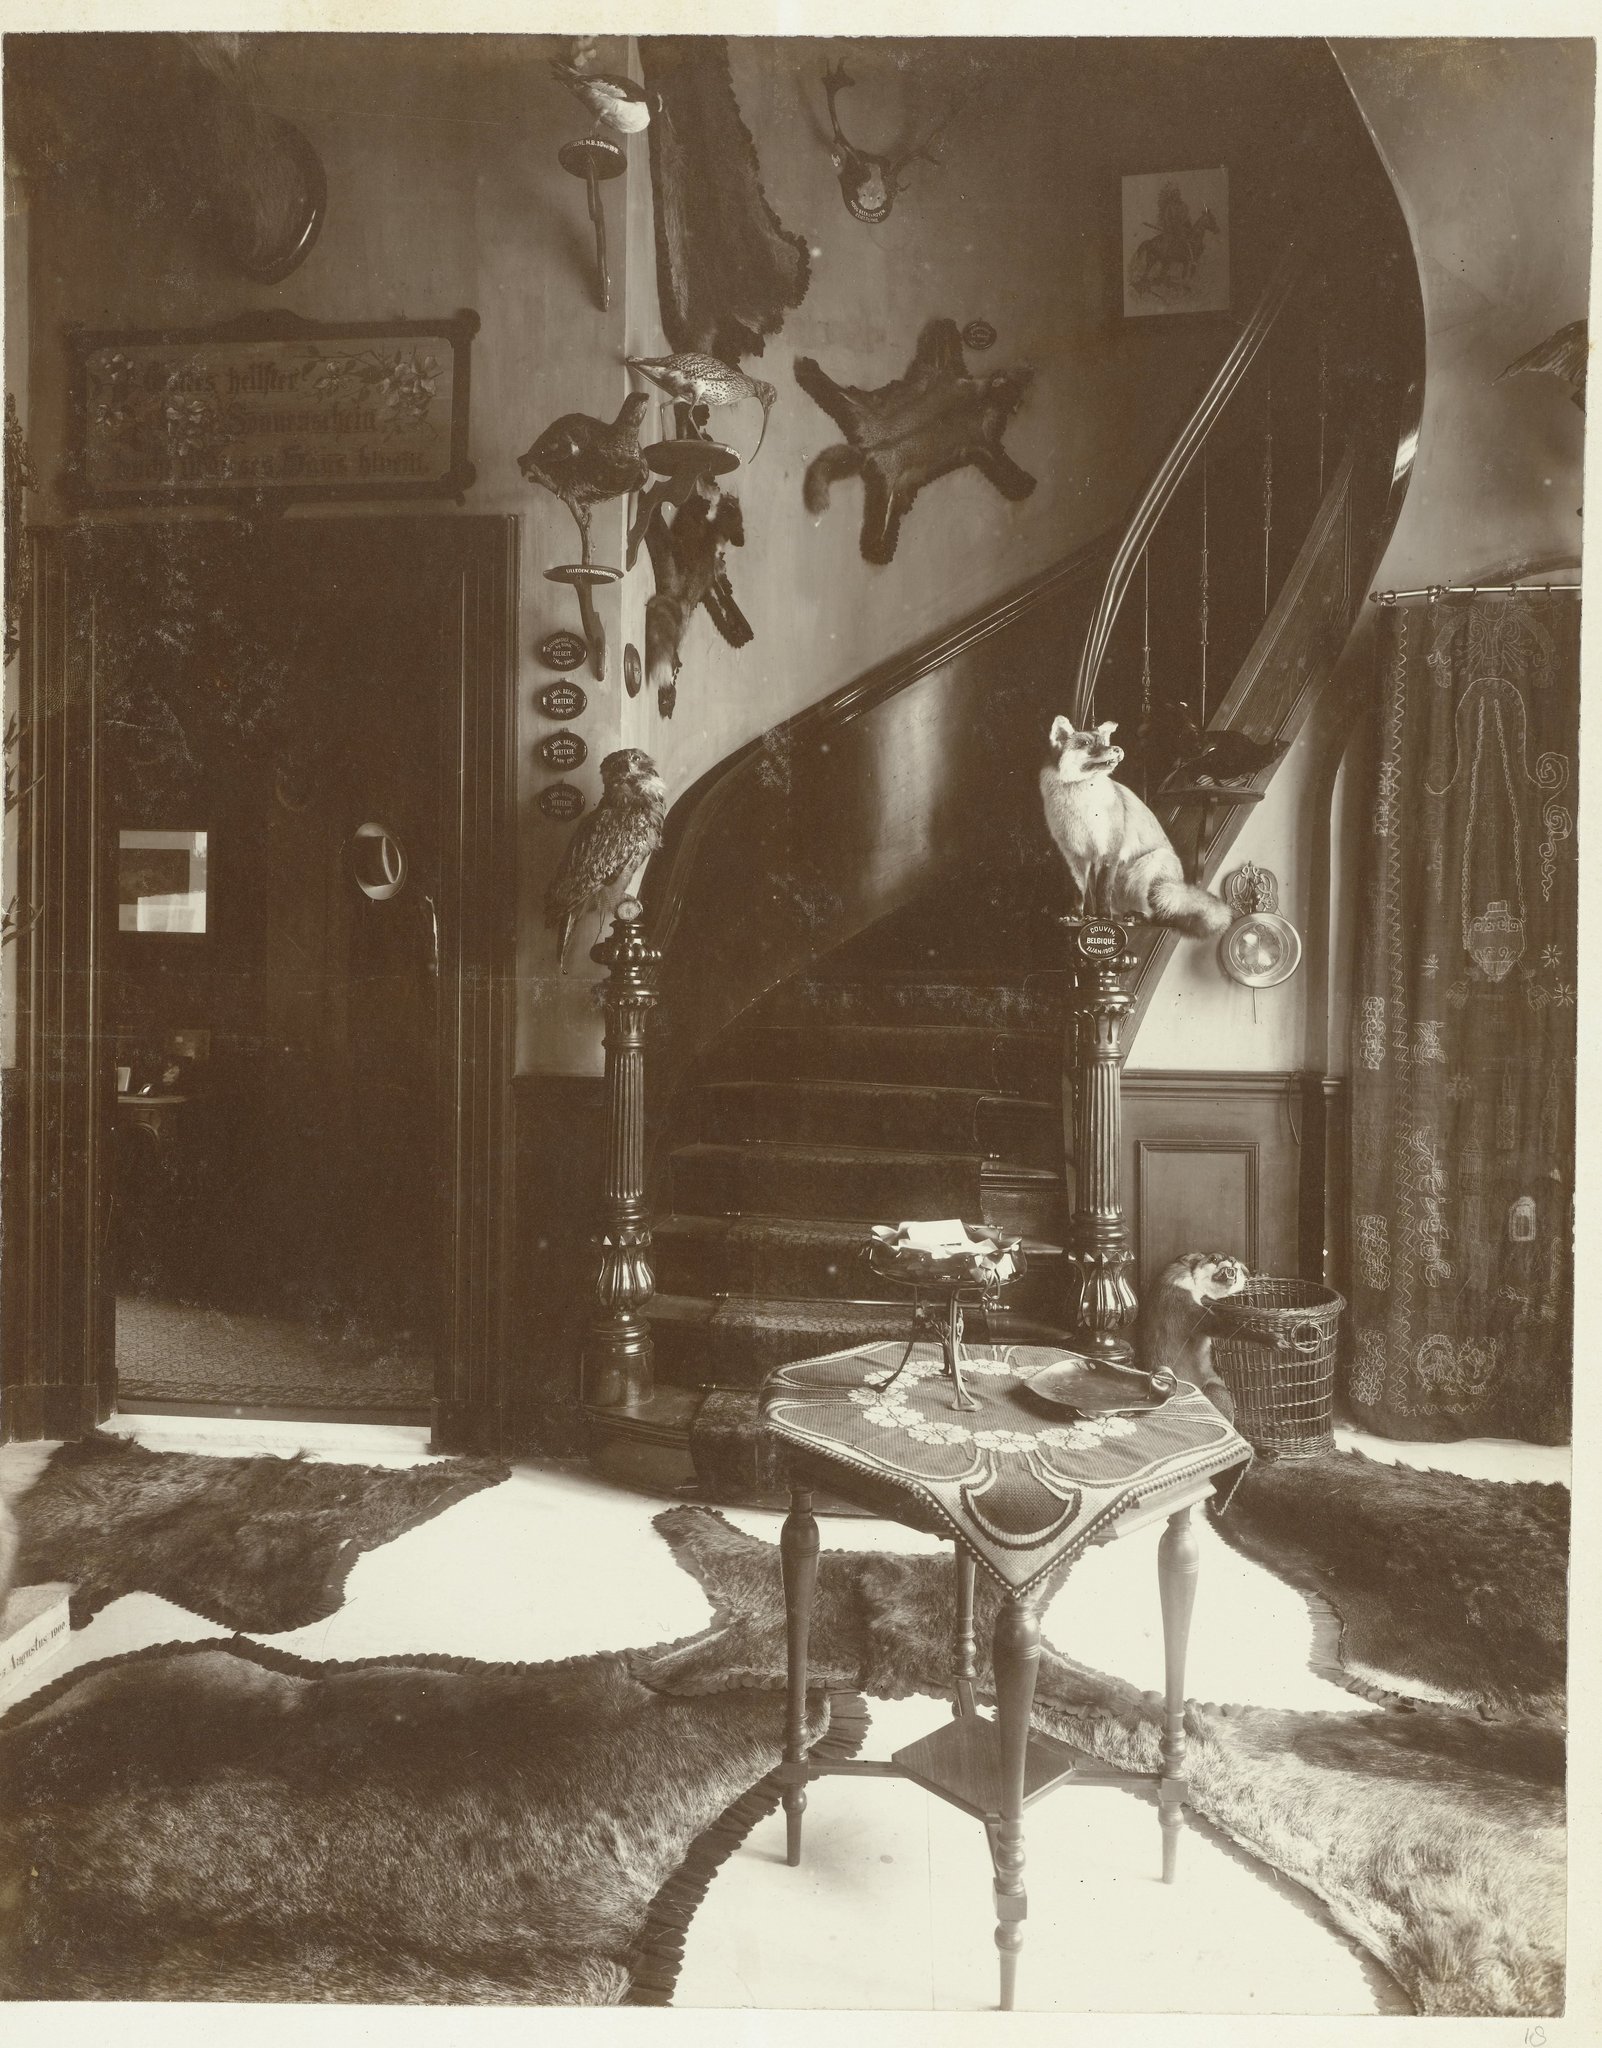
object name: photograph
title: Trap in de hal van landhuis De Wildbaan met jachttrofeeën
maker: henry pauw van wieldrecht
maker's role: fotograaf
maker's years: 1863-1912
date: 1903-1907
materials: paper, photographic support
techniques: gelatin silver print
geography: netherlands